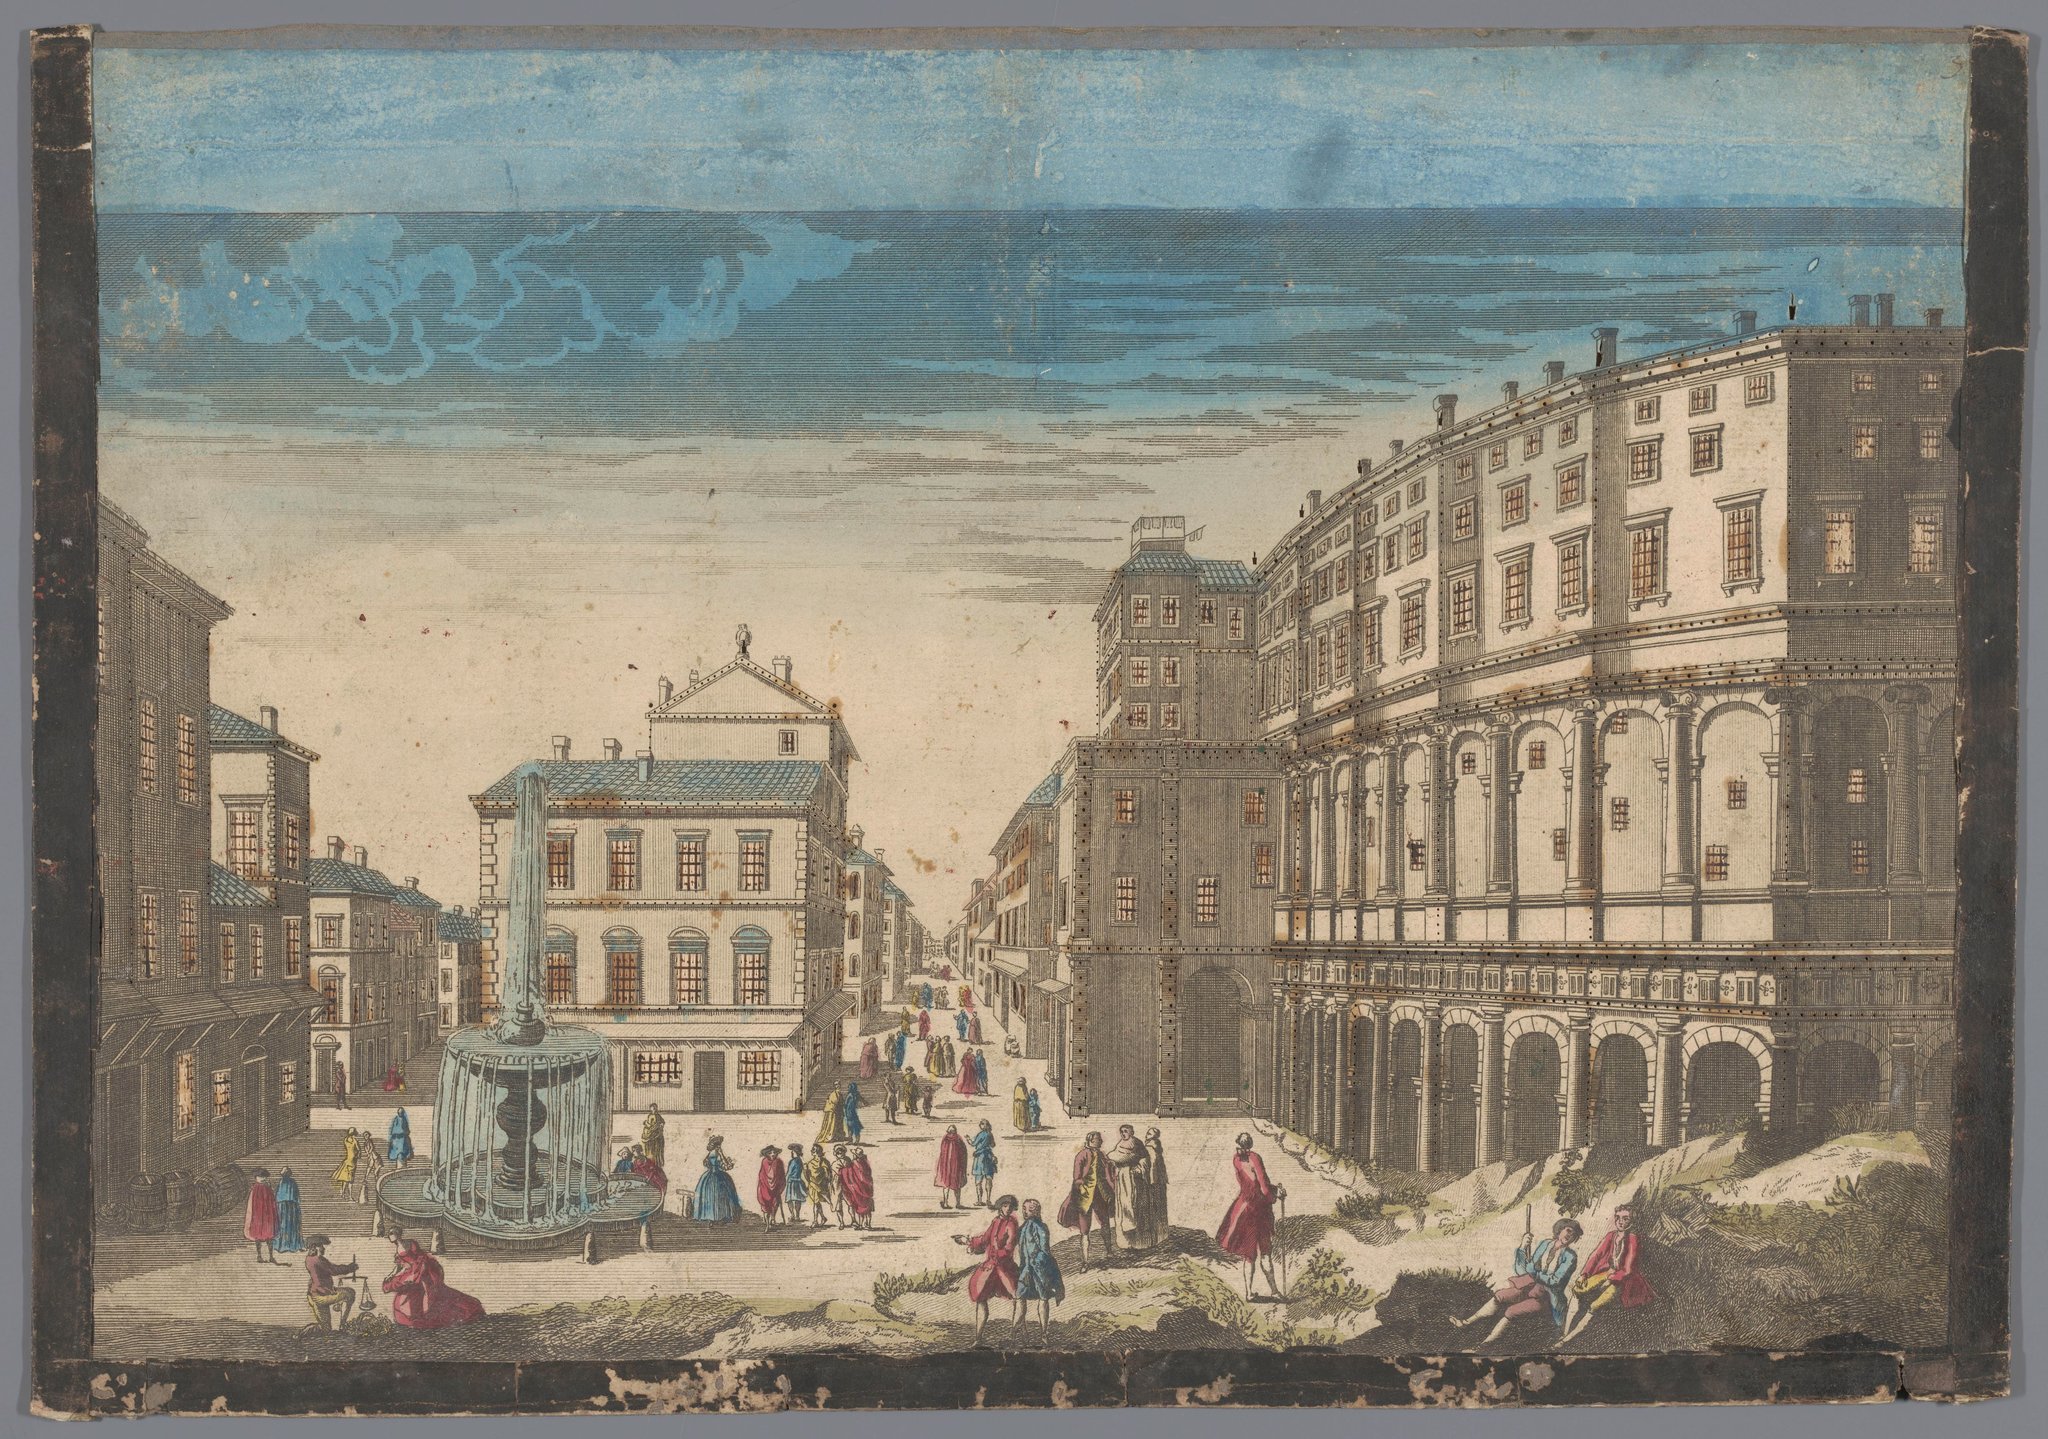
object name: opticaprent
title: Gezicht op het Theater van Marcellus te Rome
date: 1745-1775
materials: cardboard, paint, paper, watercolor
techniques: brush, cutting, etching, perforating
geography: paris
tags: theatre (building), square, place, circus, etc. (+ city(-scape) with figures, staffage), ornamental fountain (+ city(-scape) with figures, staffage), street (+ city(-scape) with figures, staffage)